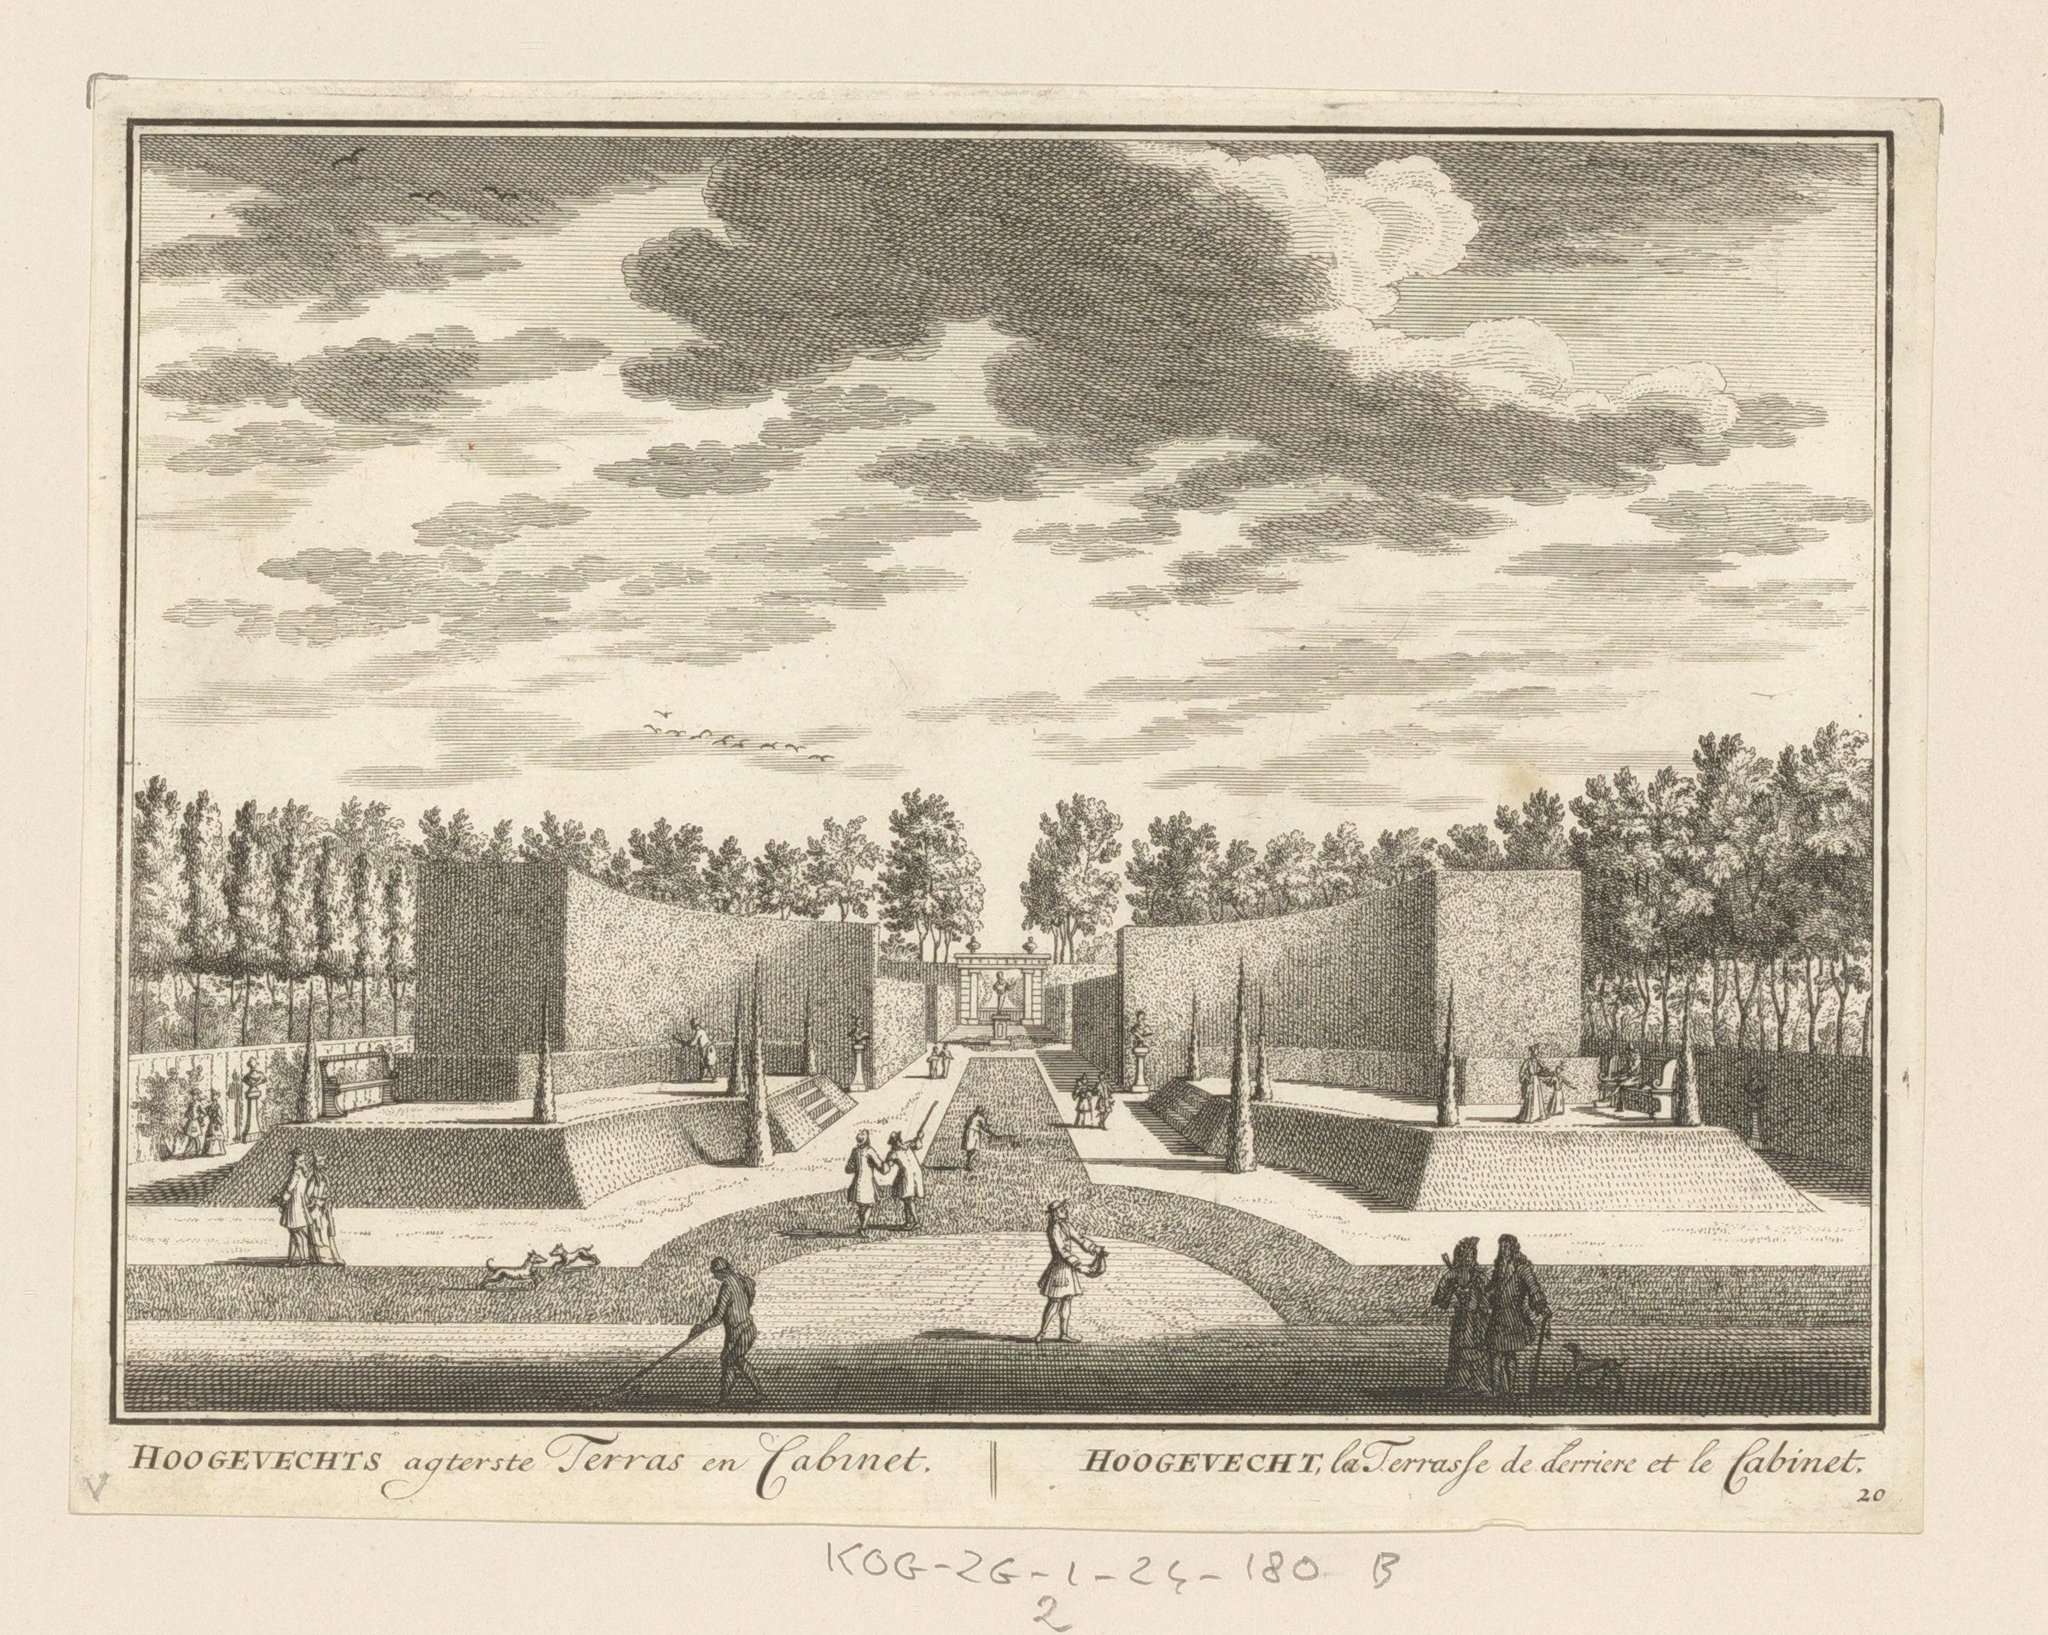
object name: print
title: Hoogevechts agterste Terras en Cabinet / Hoogevecht, la Terrasse de derriere et le Cabinet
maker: hendrik de leth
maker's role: draughtsman, print maker, publisher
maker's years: 1703-1766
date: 1729-1732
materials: paper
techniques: engraving, etching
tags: french or architectonic garden; formal garden, country-house, vecht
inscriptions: collector's mark: Lugt 1641, stamp, stamp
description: Prent mogelijk uit: Brouërius van Nidek, Matthaeus. Het zegepralend Kennemerland, vertoond in 100 heerlyke gezichten. Amsterdam: Jan Roman, s.a. Of uit: Brouërius van Nidek, Matthaeus. Het zegepralend Kennemerland, vertoond in veele heerlyke gezichten. Amsterdam: Andries en Hendrik de Leth, s.a [1729-1732]. Of uit: Brouërius van Nidek, Matthaeus. Het zegepralend Kennemerland, vertoond in veele heerlyke gezichten. Amsterdam: Jan Roman, s.a.